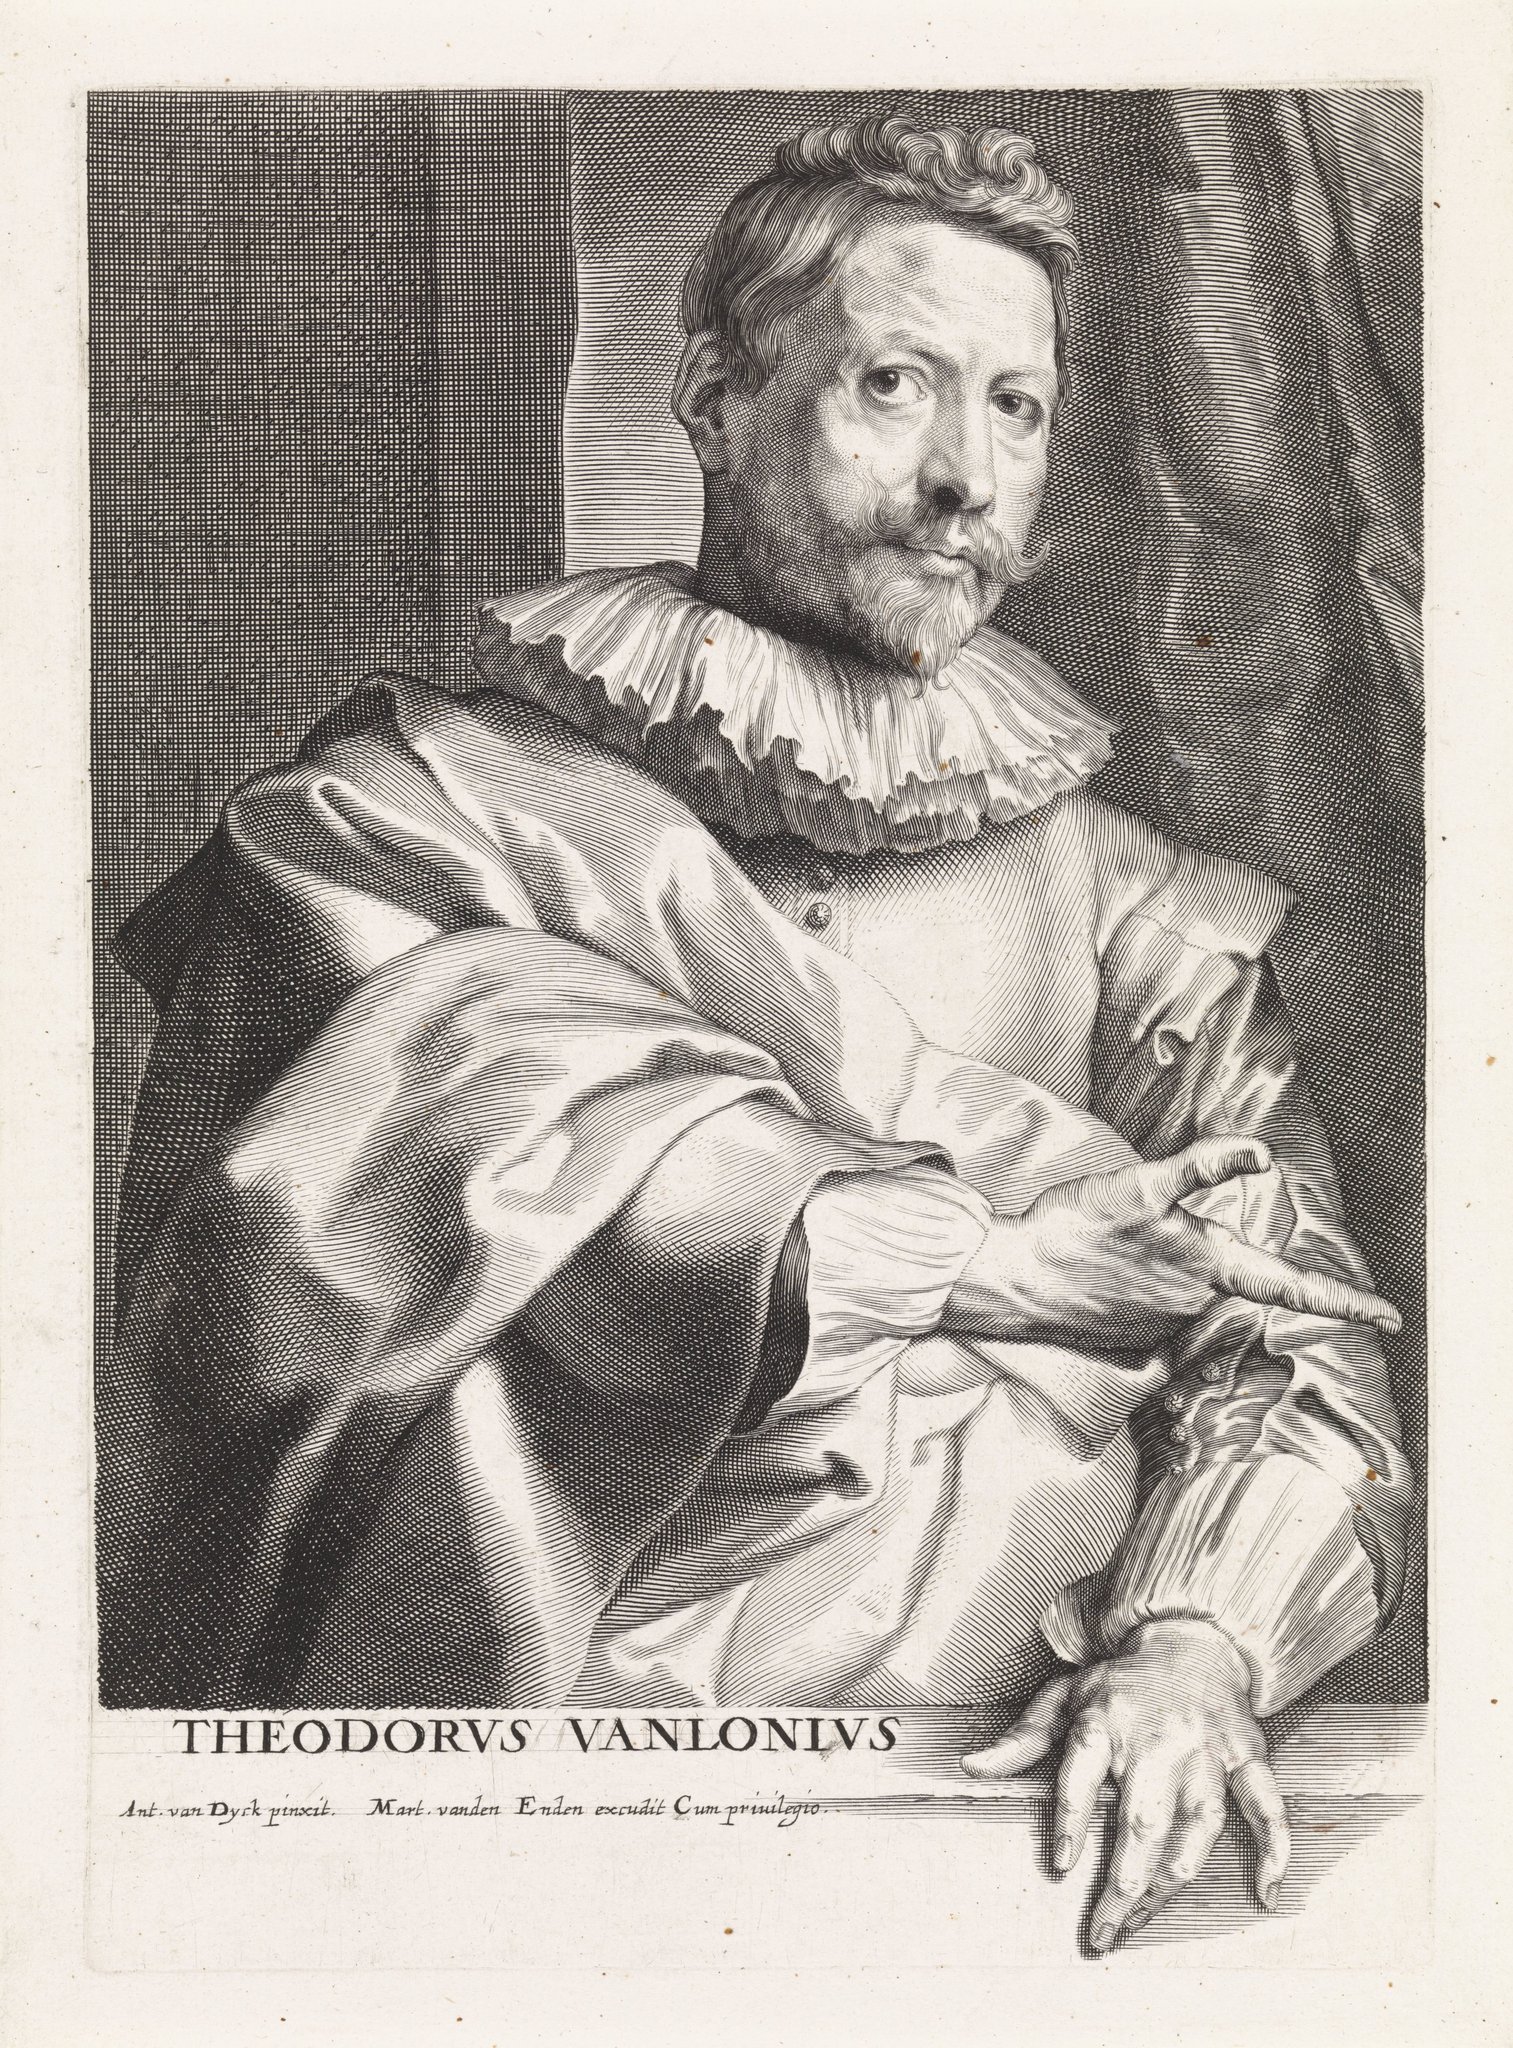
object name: print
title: Portret van de schilder Theodoor van Loon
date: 1616-1657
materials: paper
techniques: engraving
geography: antwerp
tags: painter, theodoor van loon, portrait, self-portrait of painter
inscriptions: collector's mark: Lugt 240